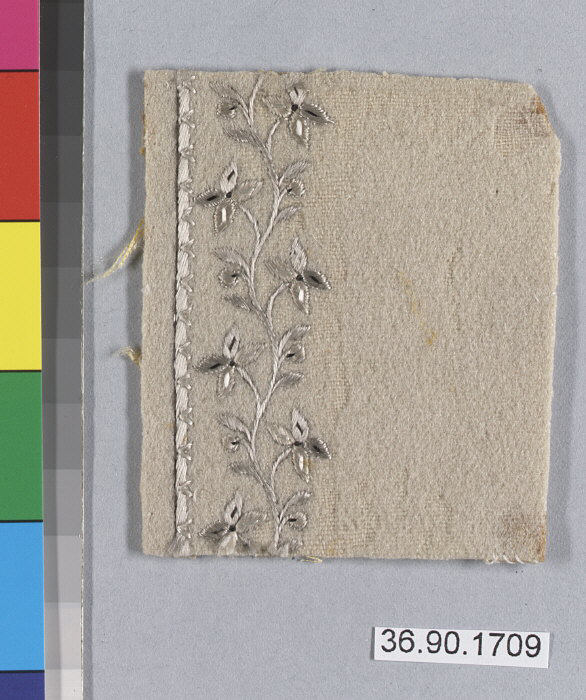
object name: sample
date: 1801-1833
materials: felt, silk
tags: flowers